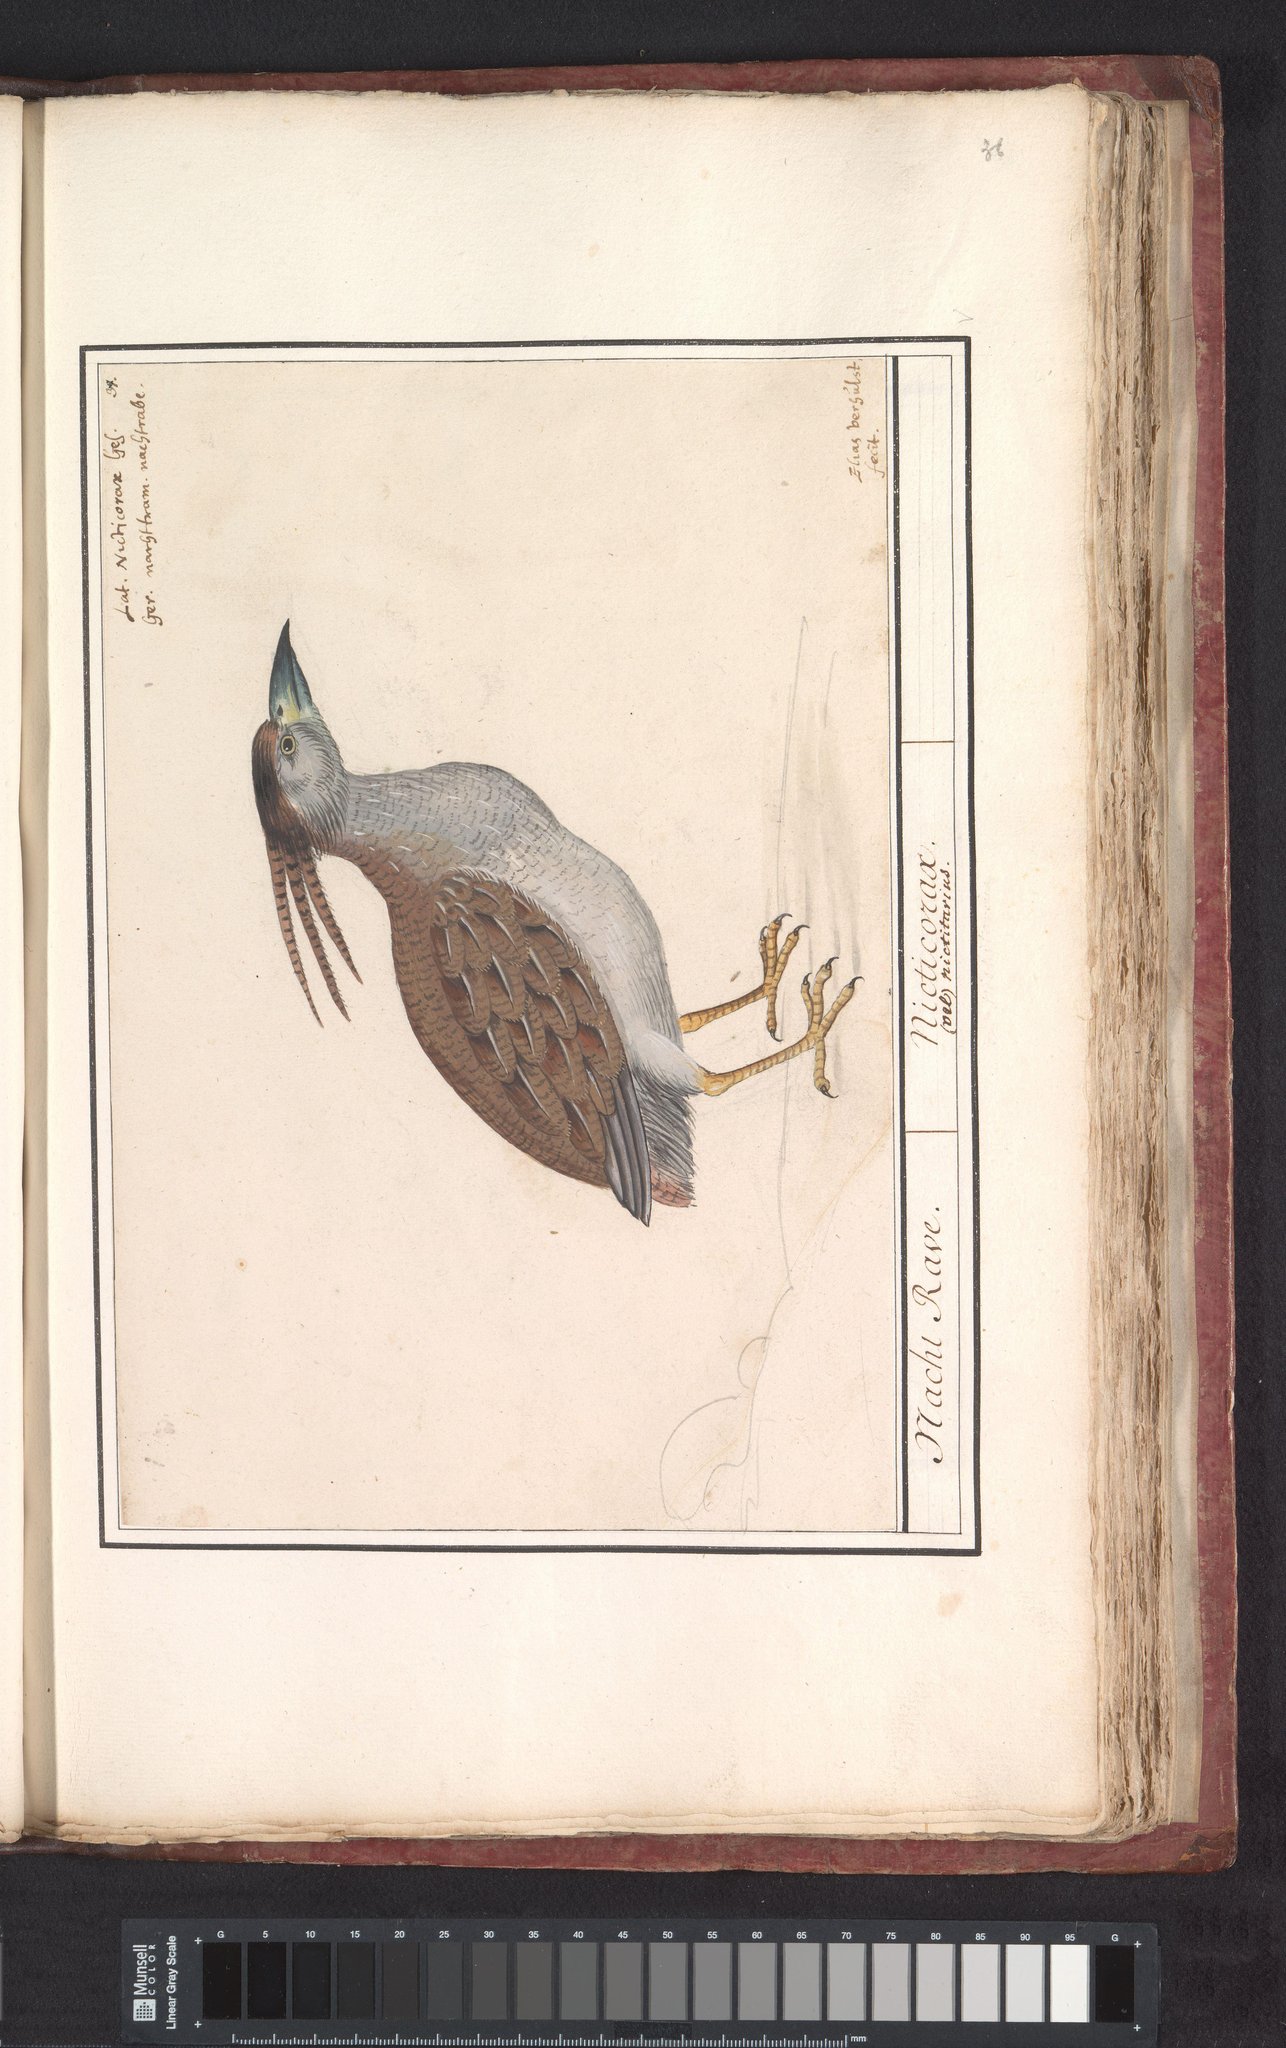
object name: drawing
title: Kwak (Nycticorax nycticorax)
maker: elias verhulst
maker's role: draughtsman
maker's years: 1565-1601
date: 1596-1610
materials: chalk, paint, ink, paper, pencil, watercolor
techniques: brush, pen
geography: delft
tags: shore-birds and wading-birds: night heron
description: Kwak. Genummerd rechtsboven: 31. Met de Latijnse en Duitse naam. Onderdeel van het derde album met tekeningen van vogels. Vijfde van twaalf albums met tekeningen van dieren, vogels en planten bekend rond 1600, gemaakt in opdracht van keizer Rudolf II. Met toelichting in Nederlands, Latijn en Frans.